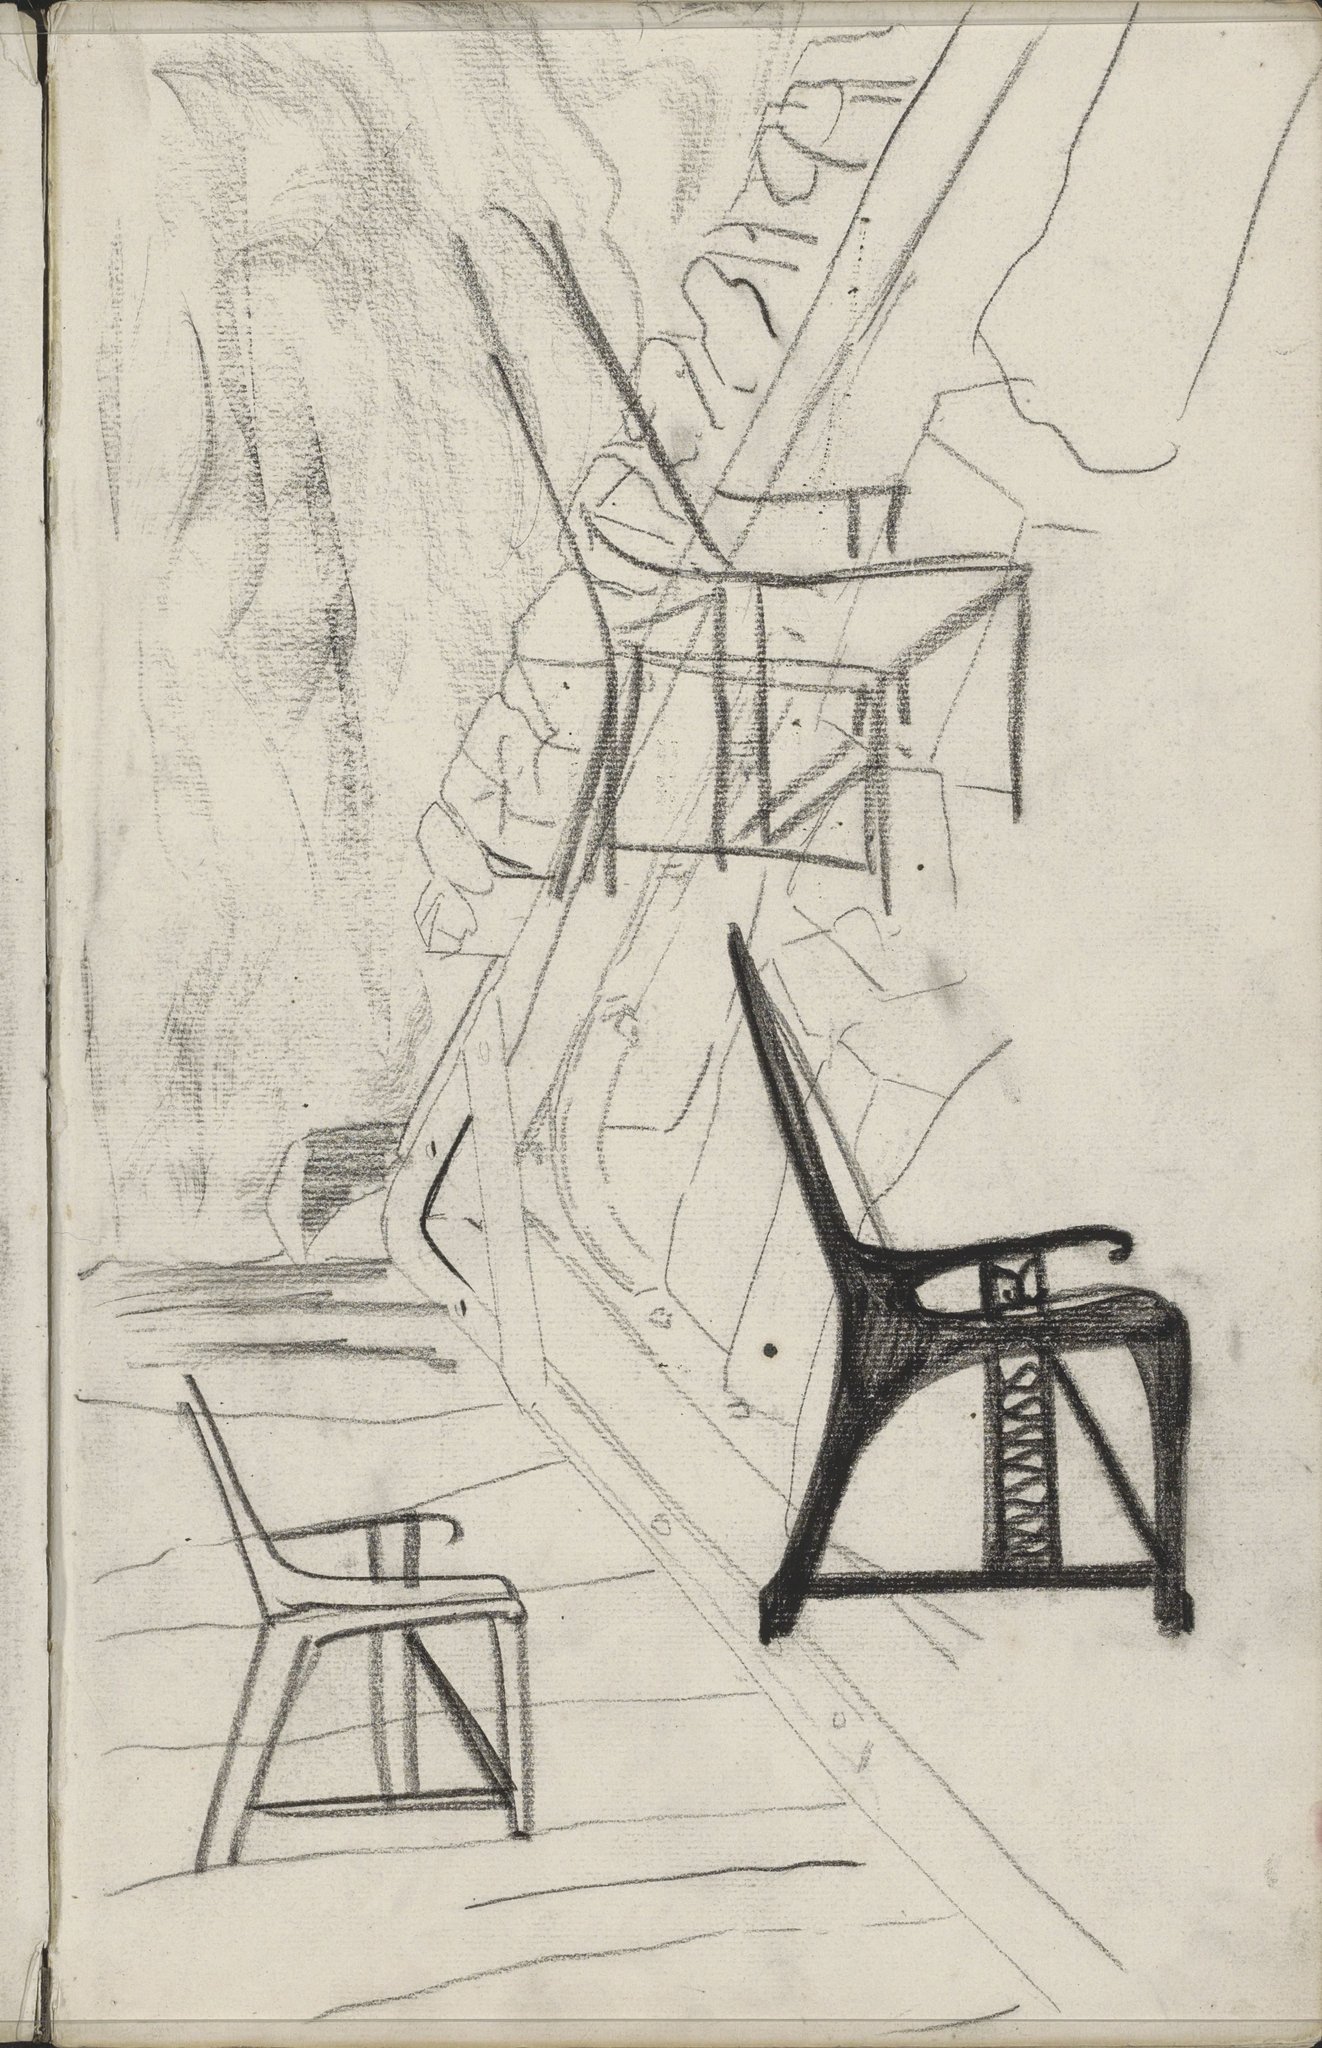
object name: sketchbook leaf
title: Ontwerpen voor stoelen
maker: carel adolph lion cachet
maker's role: draughtsman, print maker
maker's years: 1864-1945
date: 1895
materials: chalk, paper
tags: chair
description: Tevens een studie van een instrument, mogelijk een meetinstrument. Blad 3 recto uit een schetsboek met 23 bladen.